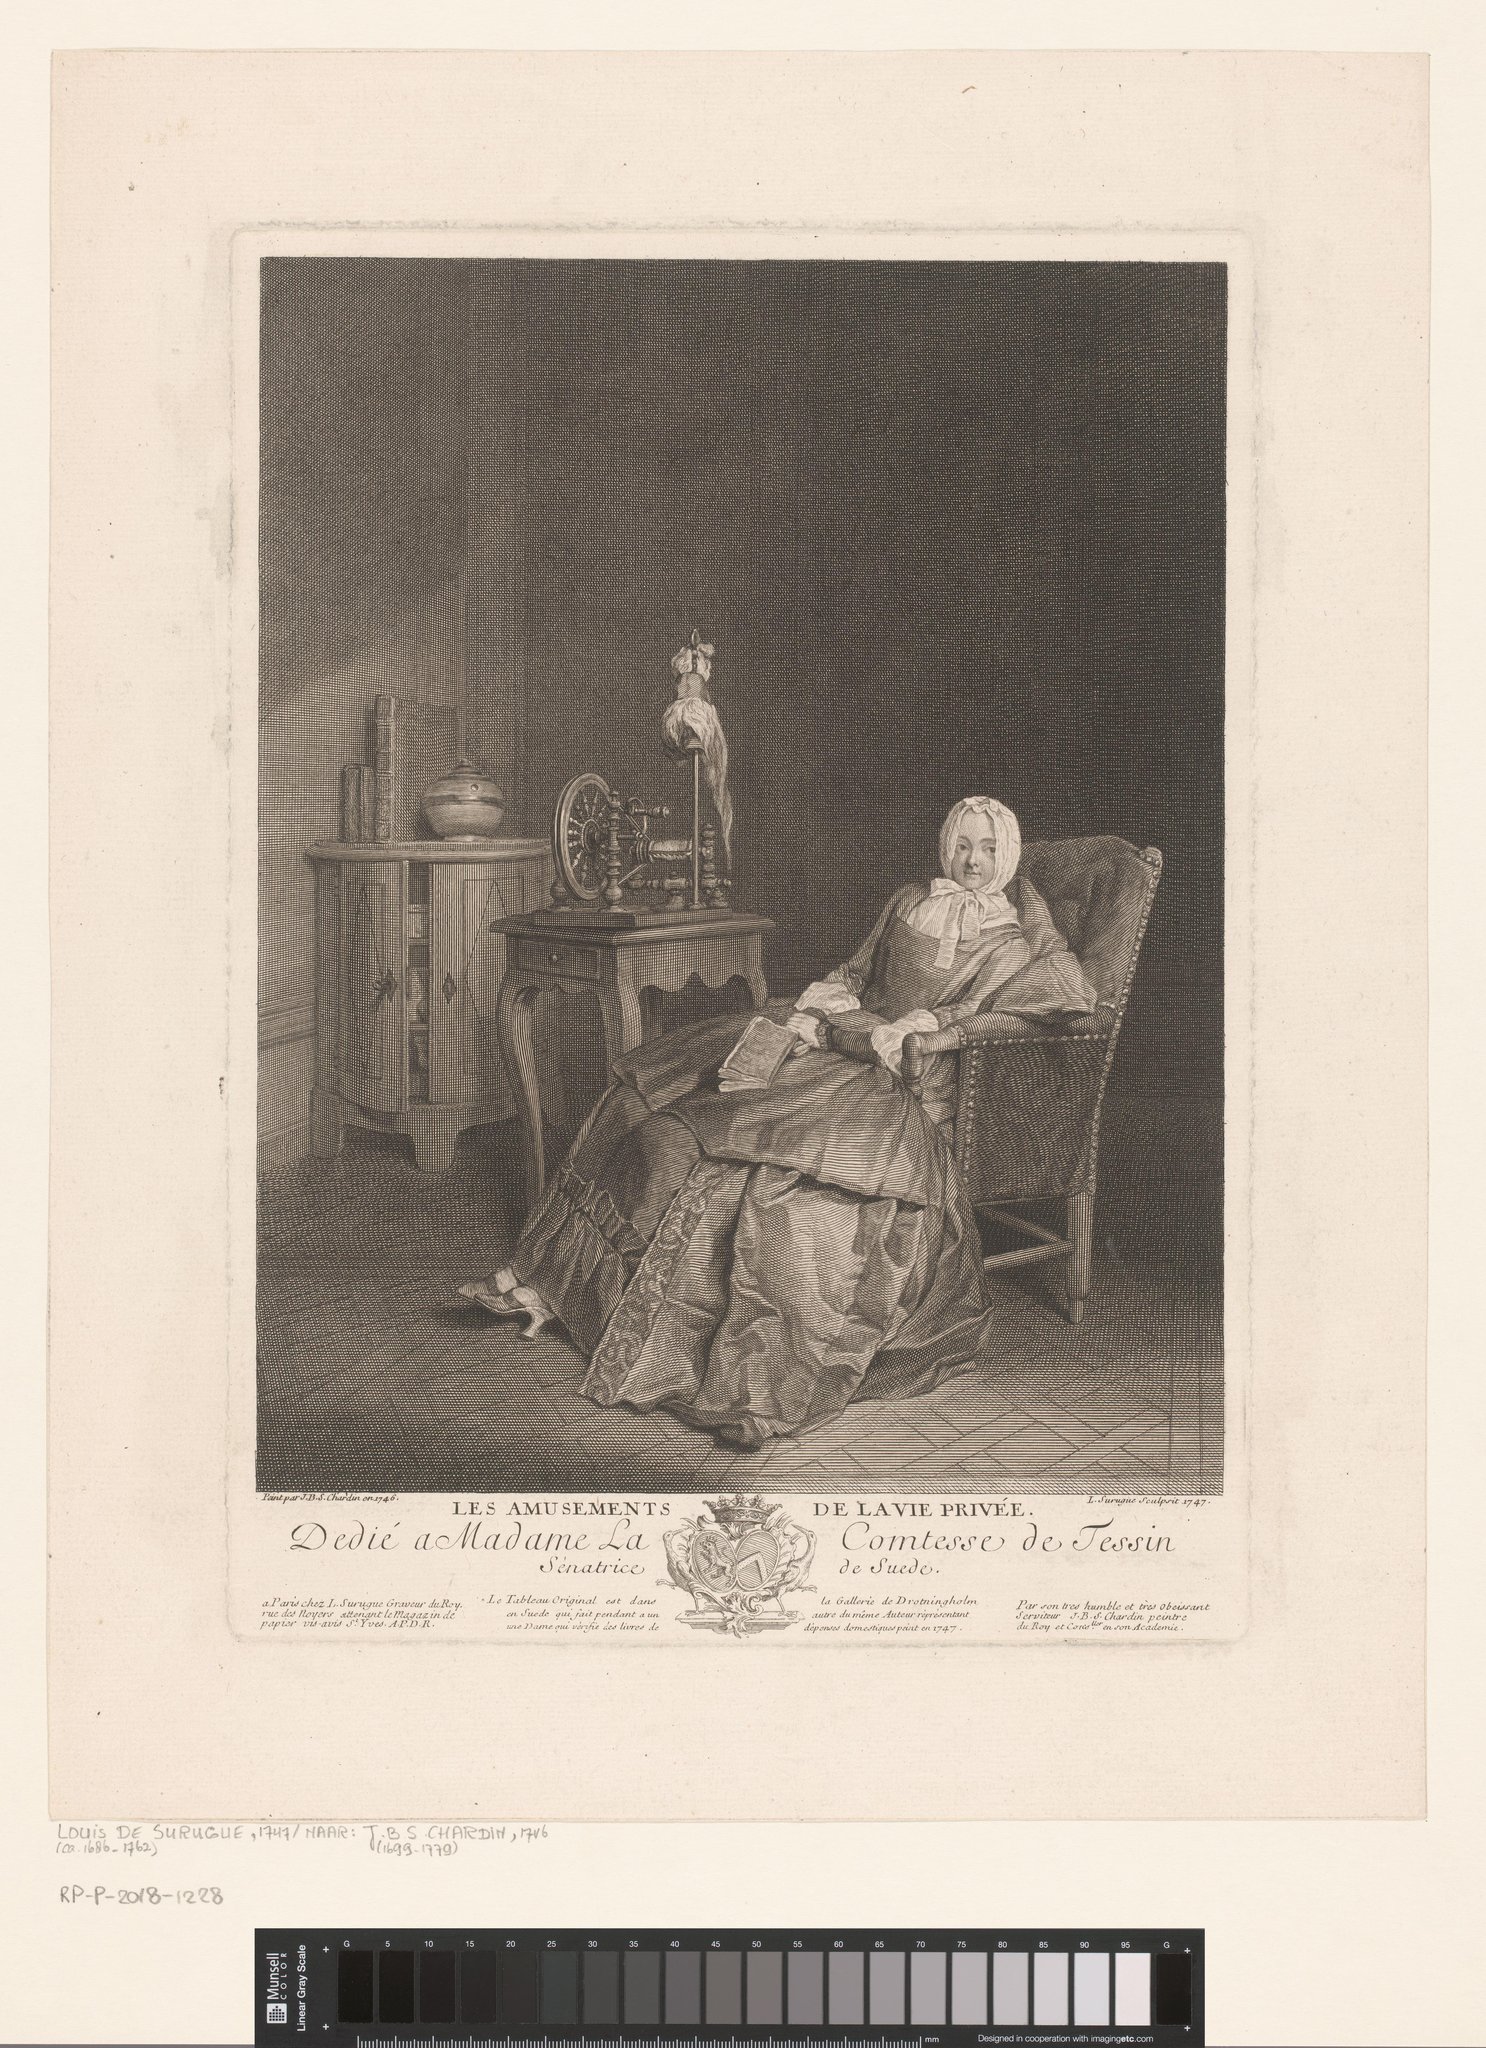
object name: print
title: Interieur met een dame met een boek op schoot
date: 1747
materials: paper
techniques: engraving, etching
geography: france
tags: reading, spinning-wheel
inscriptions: collector's mark: Lugt 2228, collector's mark: Lugt 2760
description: Schemerige kamer met een zittende elegante dame. Schuin achter haar een spinnewiel en een kastje met onder andere boeken.